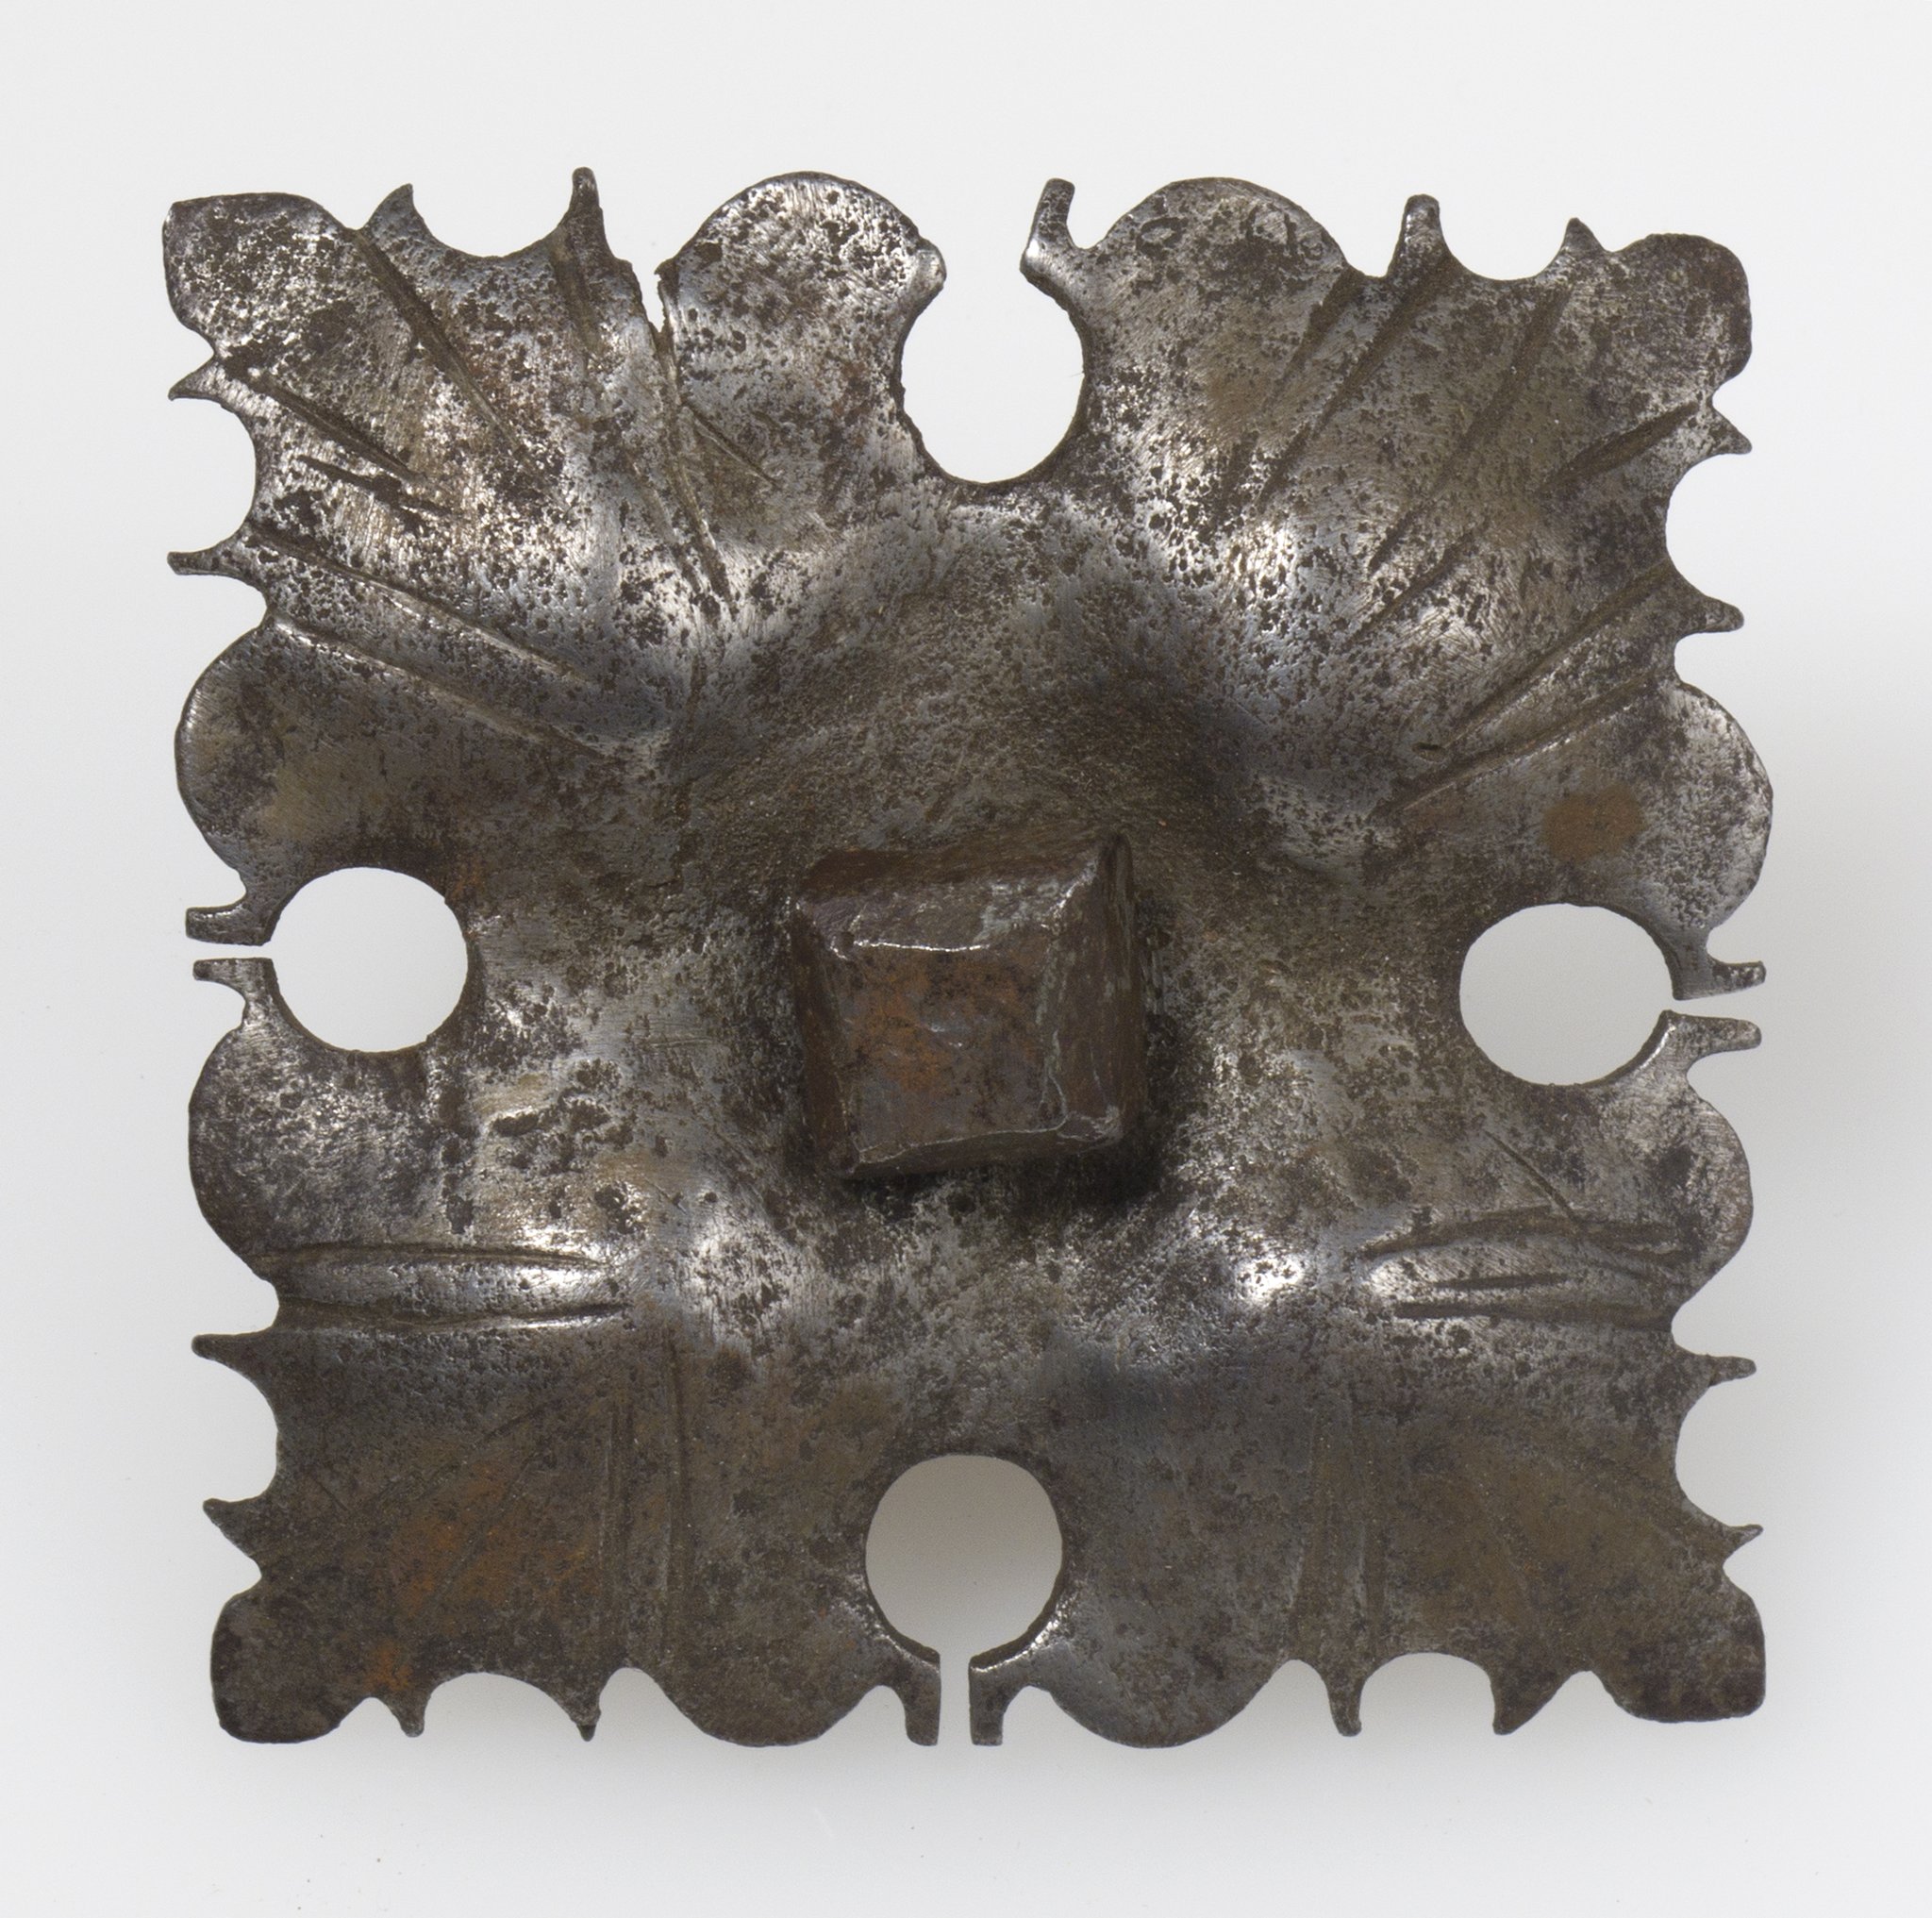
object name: plate and nail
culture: european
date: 1401-1600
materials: iron